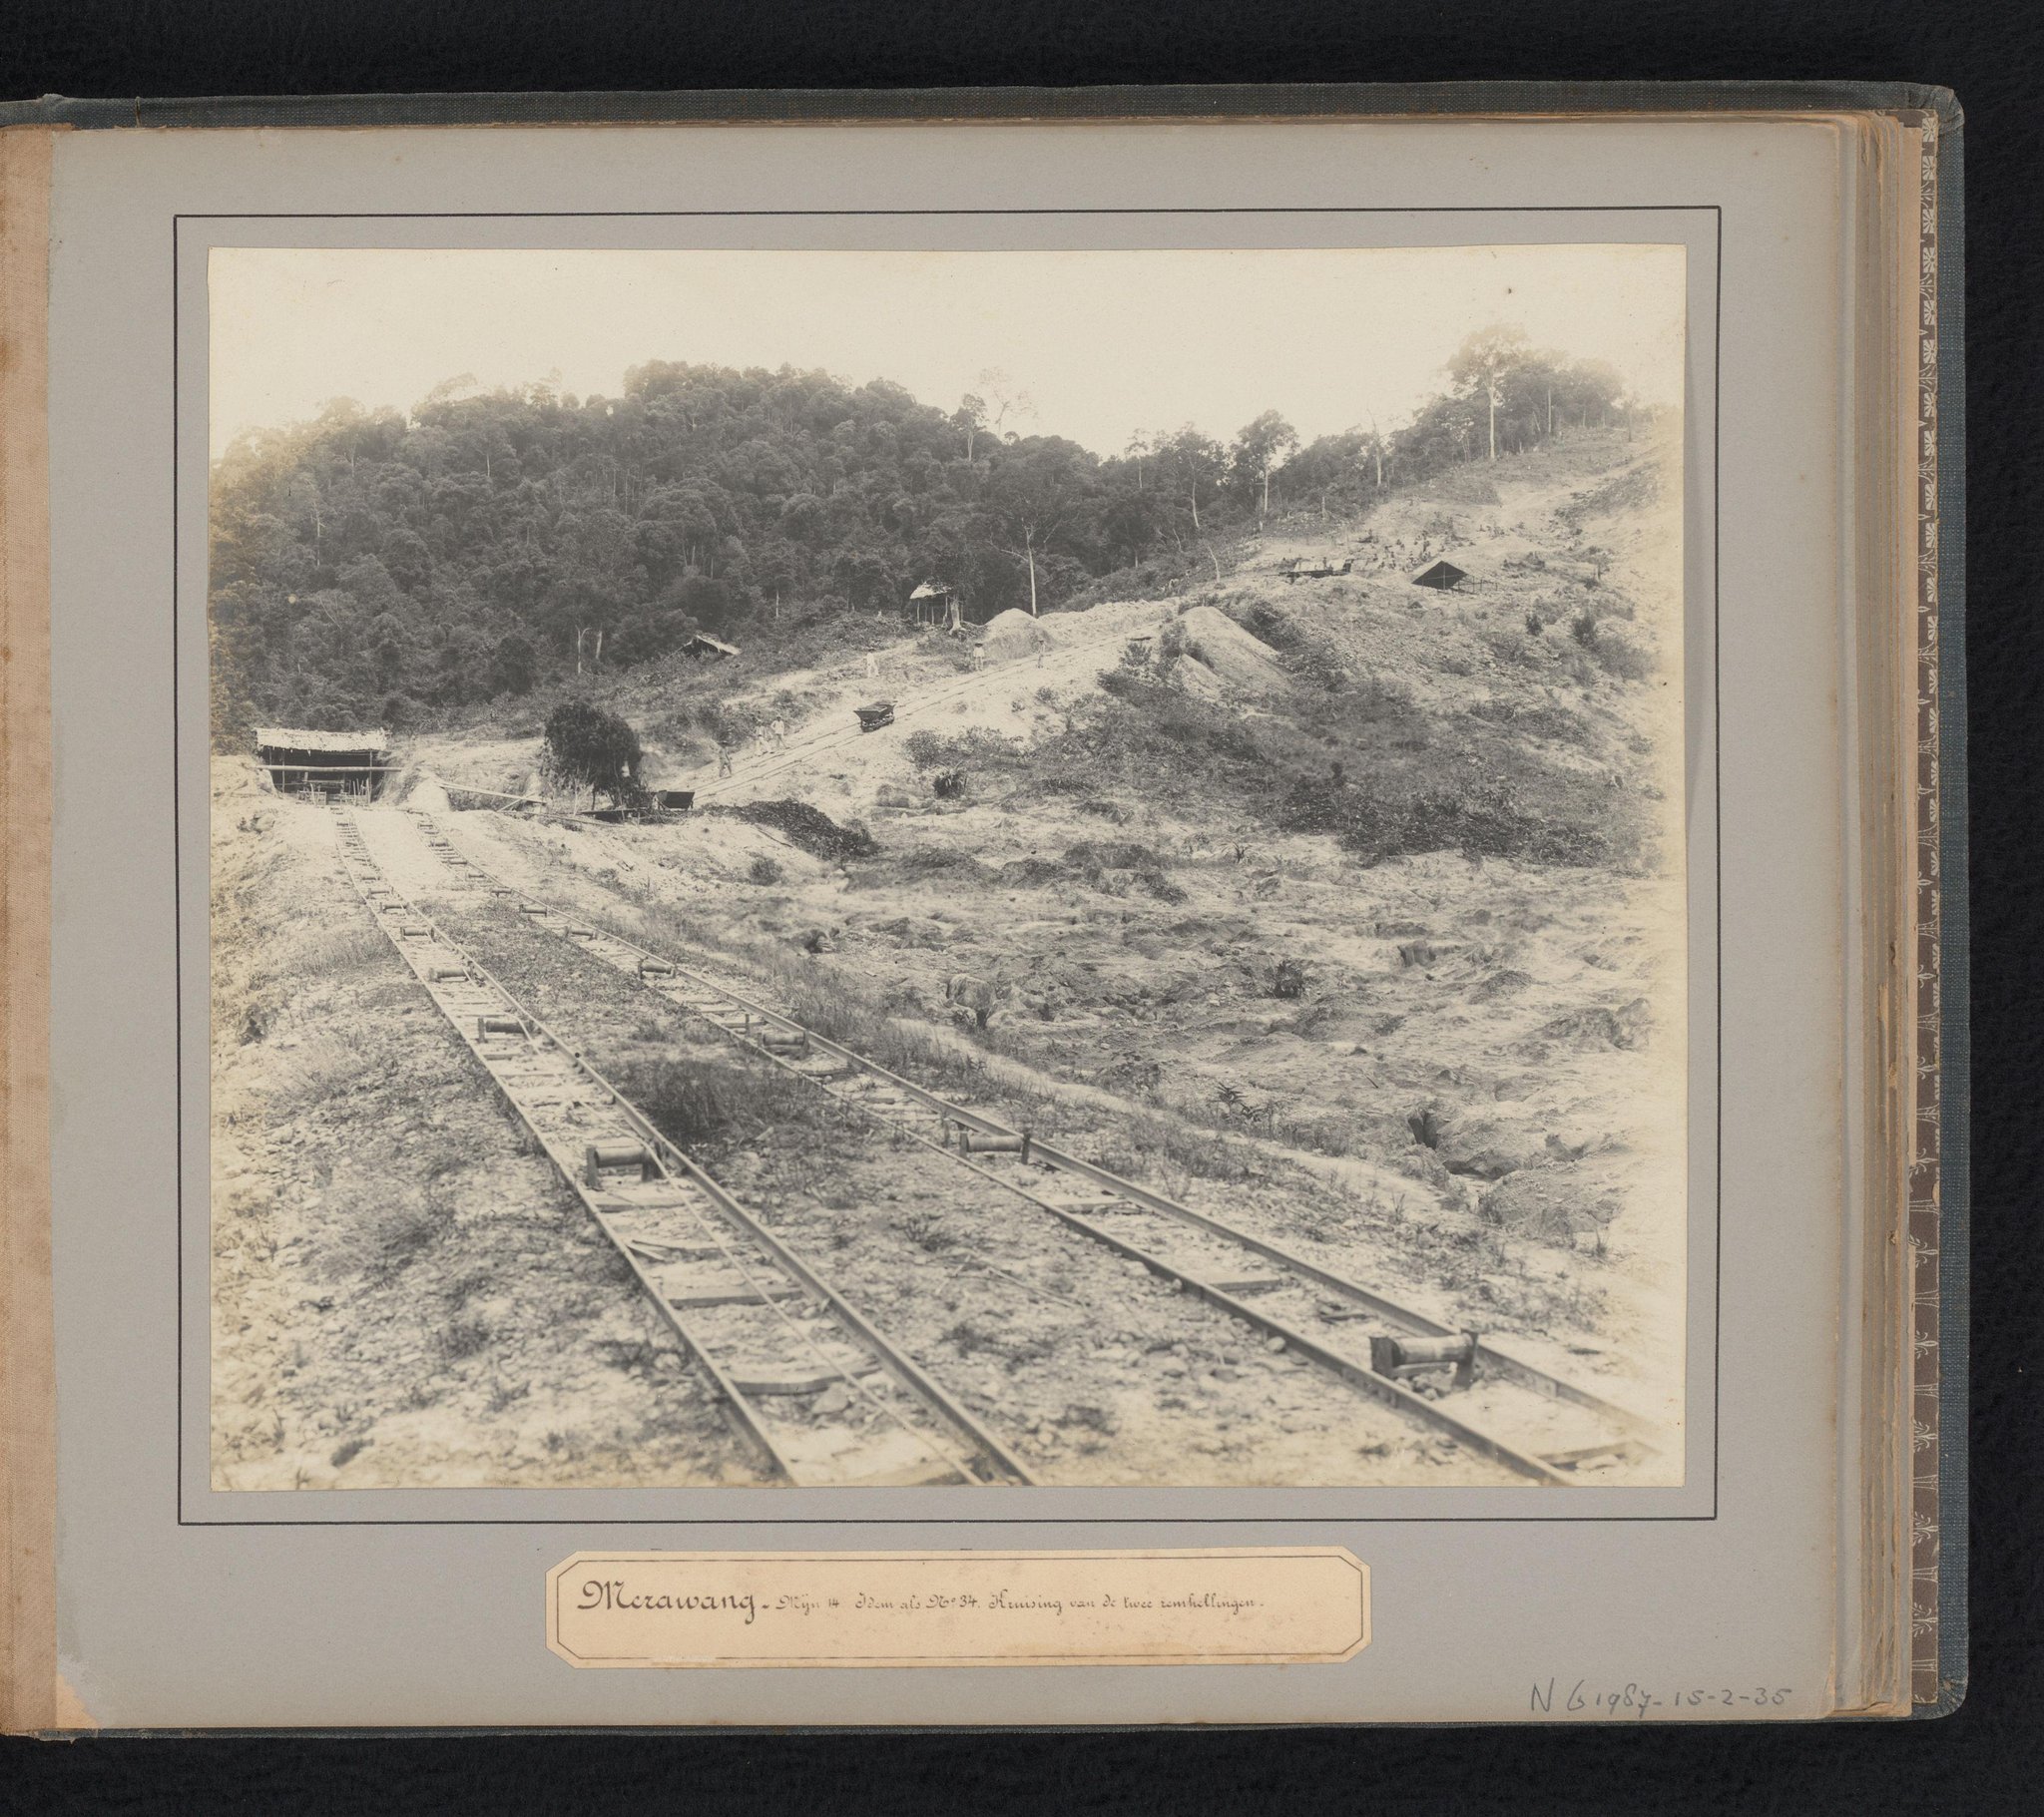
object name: photograph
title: Merawang. Mijn 14. Idem als No. 34. Kruising van de twee remhellingen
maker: Anonymous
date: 1907-1919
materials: cardboard, photographic support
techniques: gelatin silver print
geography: bangka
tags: robert julius boers, colonial system, opencast mine; strip mining, minerals and metals: tin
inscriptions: label: ‘Merawang. Mijn 14. Idem als No. 34. Kruising van de twee remhellingen.’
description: Afvoer van ertsgrond met karretjes over spoorbaantjes met remblokken bij een tinmijn van de Banka-tinwinning op een heuvel te Merawang. Onderdeel van het fotoalbum over de Banka-tinwinning, ca. 1907-1919.